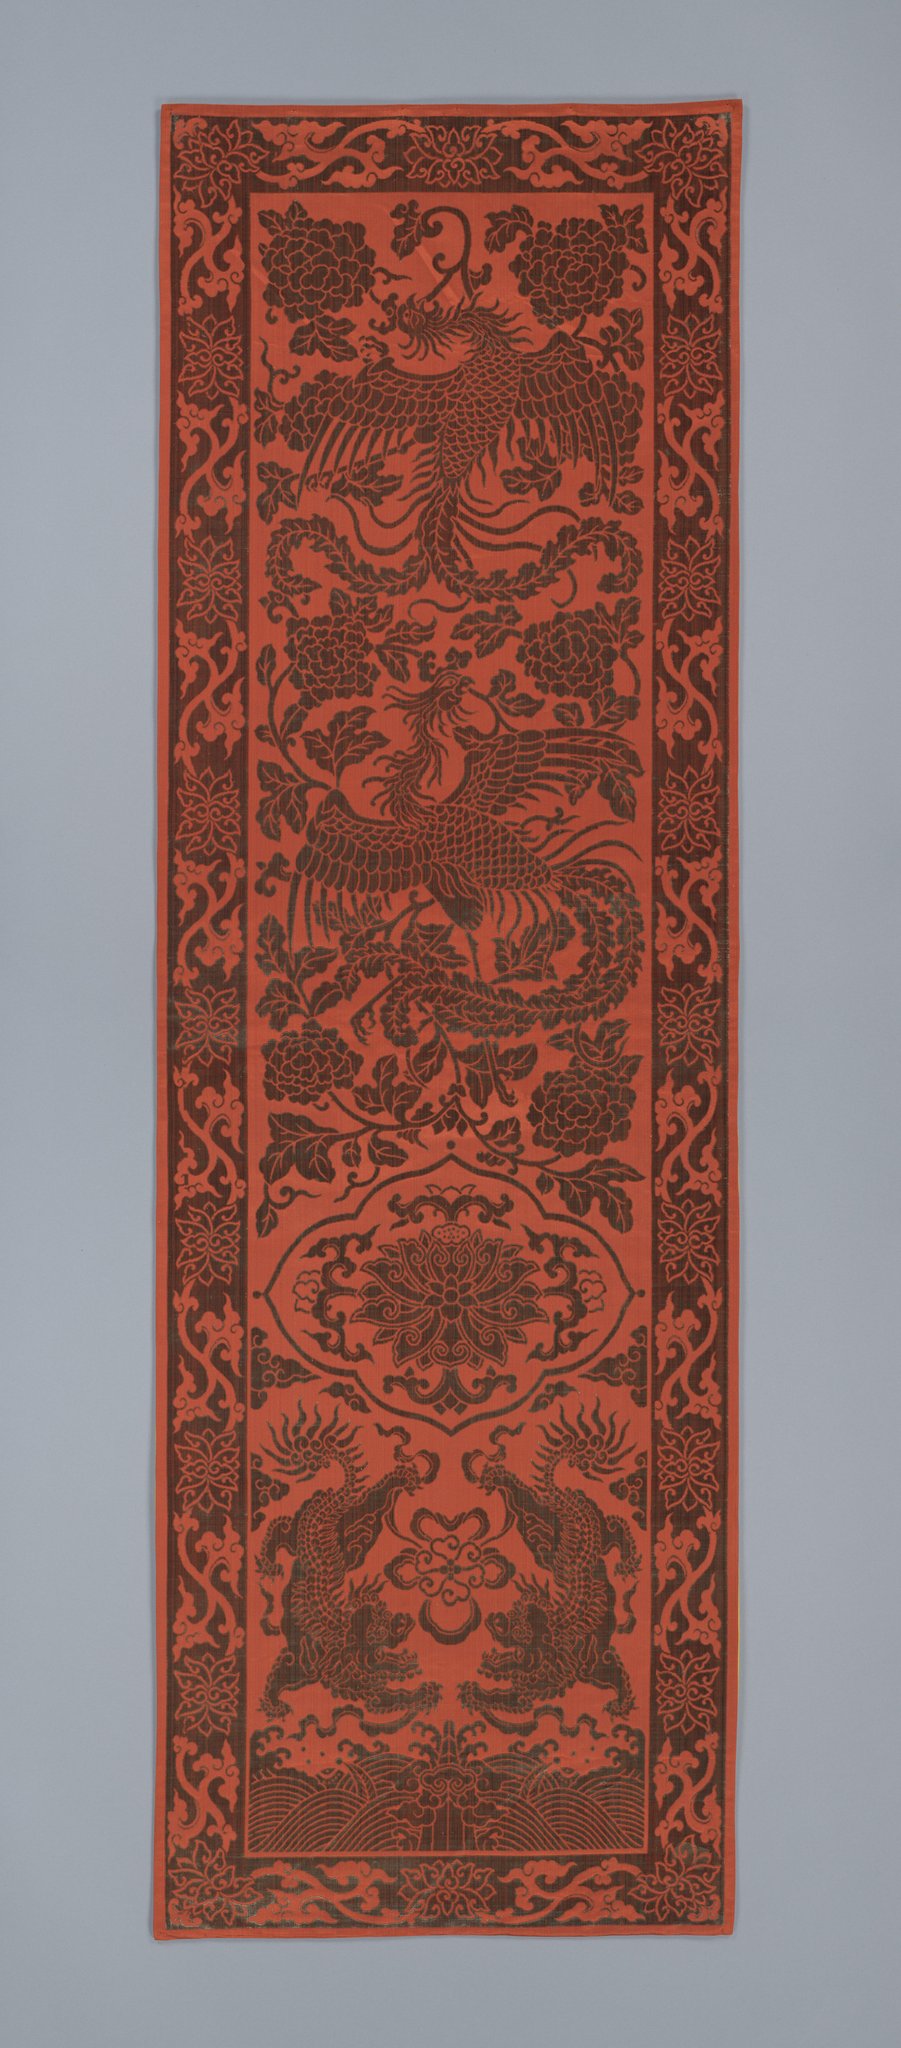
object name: chair strip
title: Chair strip with Lions and Phoenixes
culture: chinese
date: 1701-1800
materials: silk, velvet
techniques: cutting, voiding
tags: phoenix